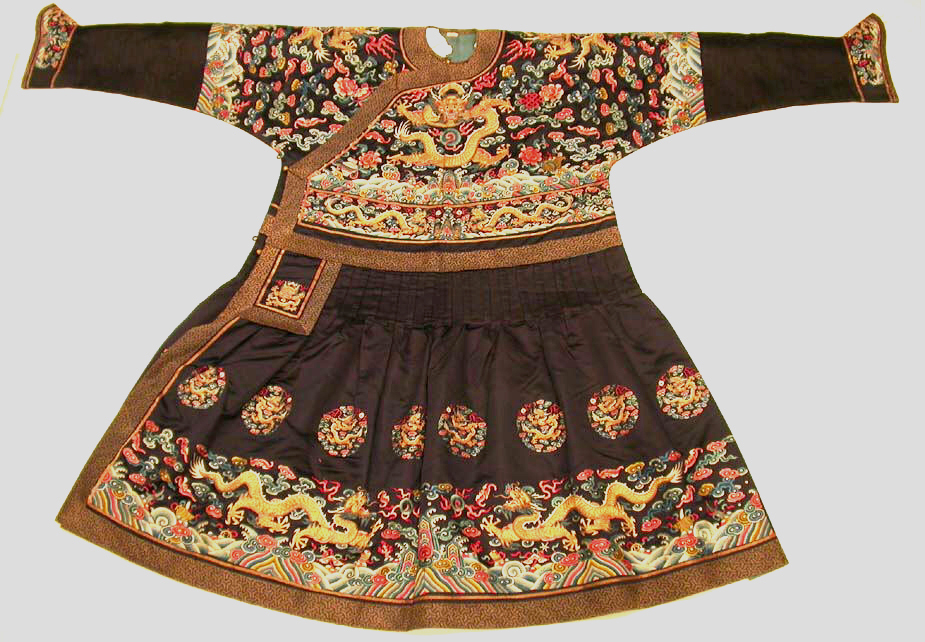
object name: robe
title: Man's Audience Robe (Chaofu)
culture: chinese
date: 1851-1900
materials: metal thread, silk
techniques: embroidery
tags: dragons